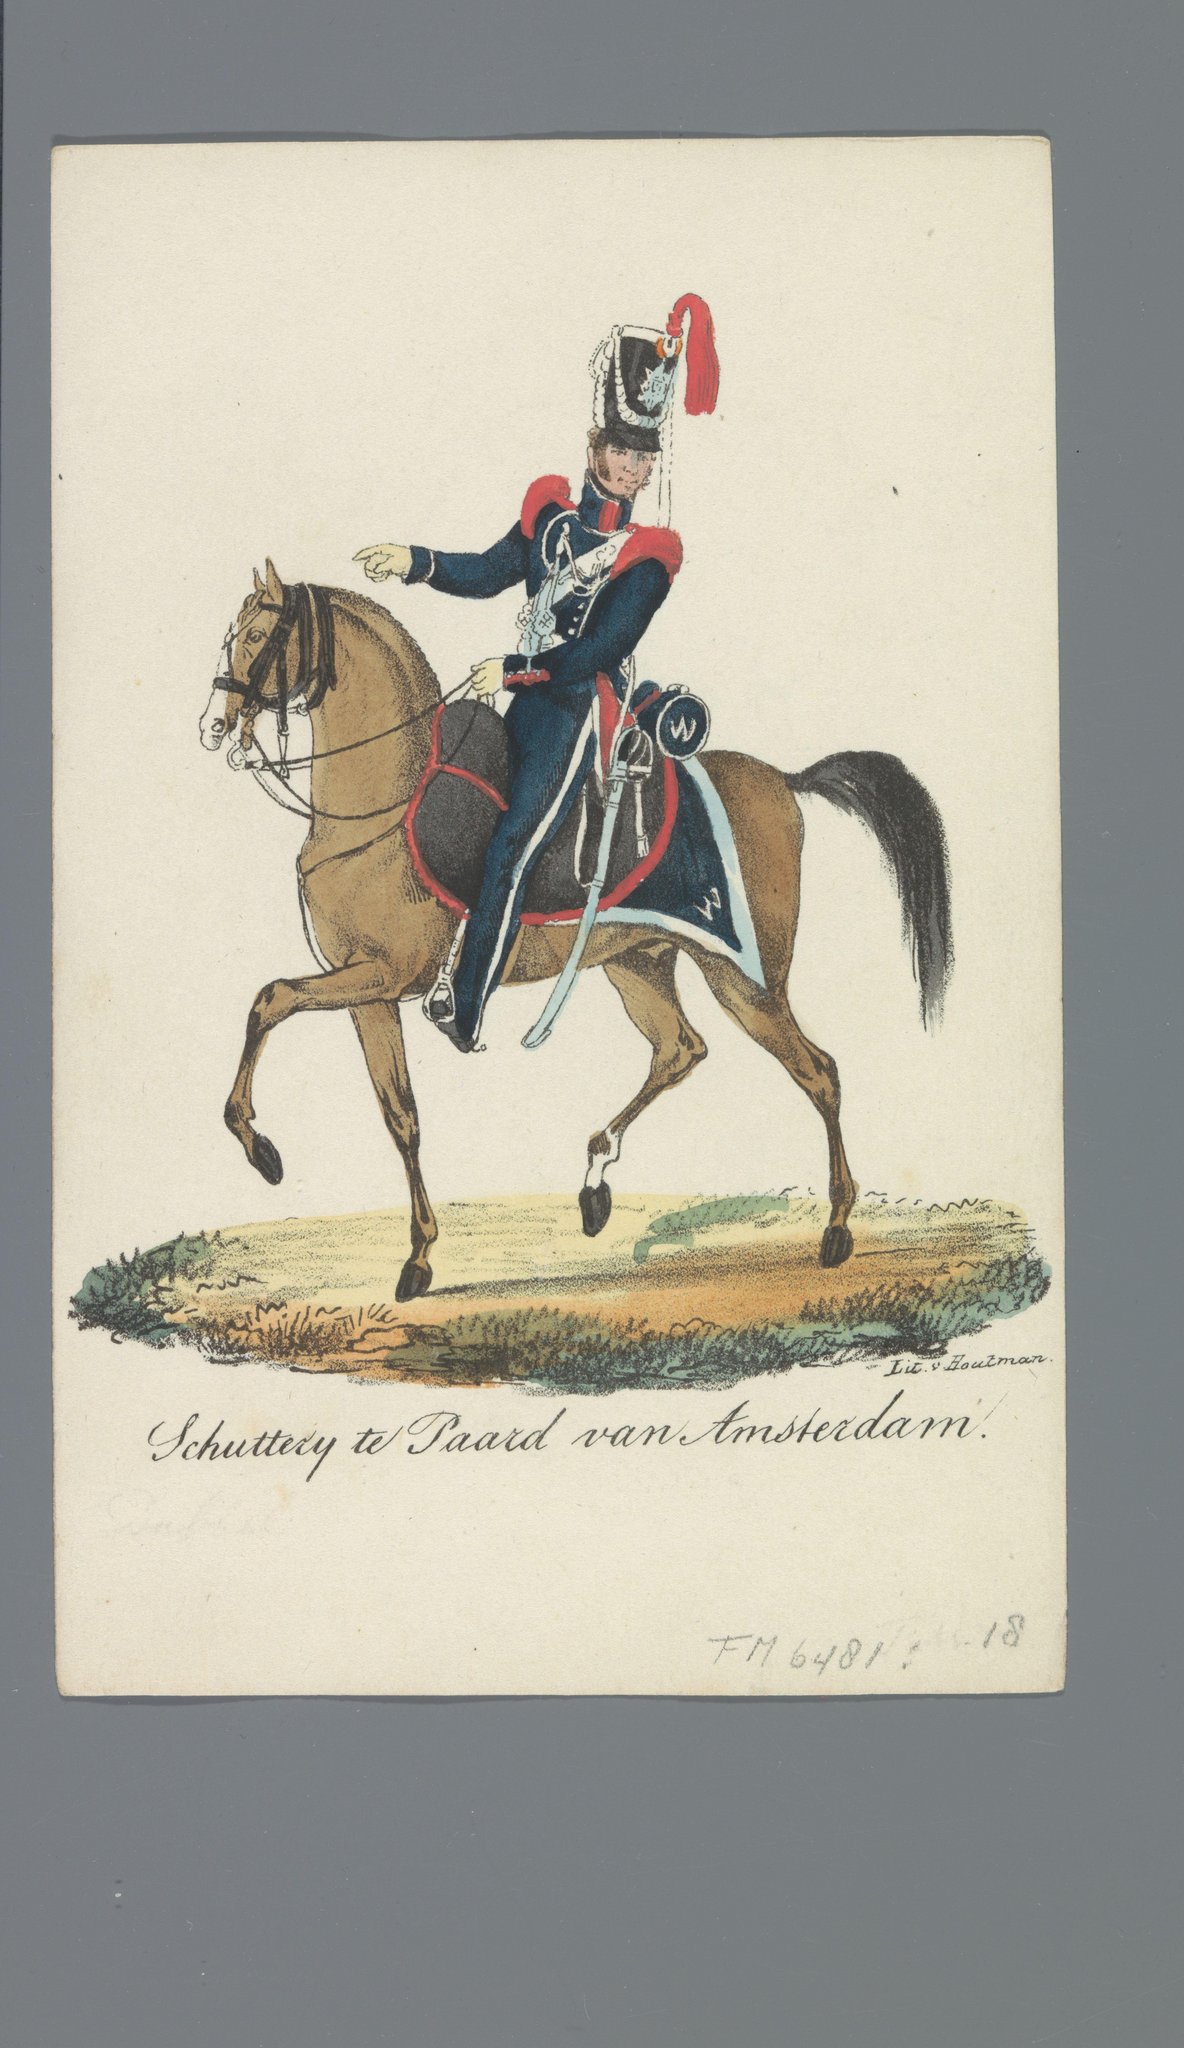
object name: print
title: Schutterij te paard van Amsterdam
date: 1835-1850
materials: paper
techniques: hand coloring, lithograph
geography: utrecht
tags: (military) uniforms, clothes, costume, amsterdam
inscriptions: collector's mark: Lugt 2228, collector's mark: Lugt 2227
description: Schutter te paard, van de Schutterij te paard van Amsterdam. Onderdeel van een serie van 157 losse bladen met Nederlandse militaire uniformen in de jaren 1830-1832.